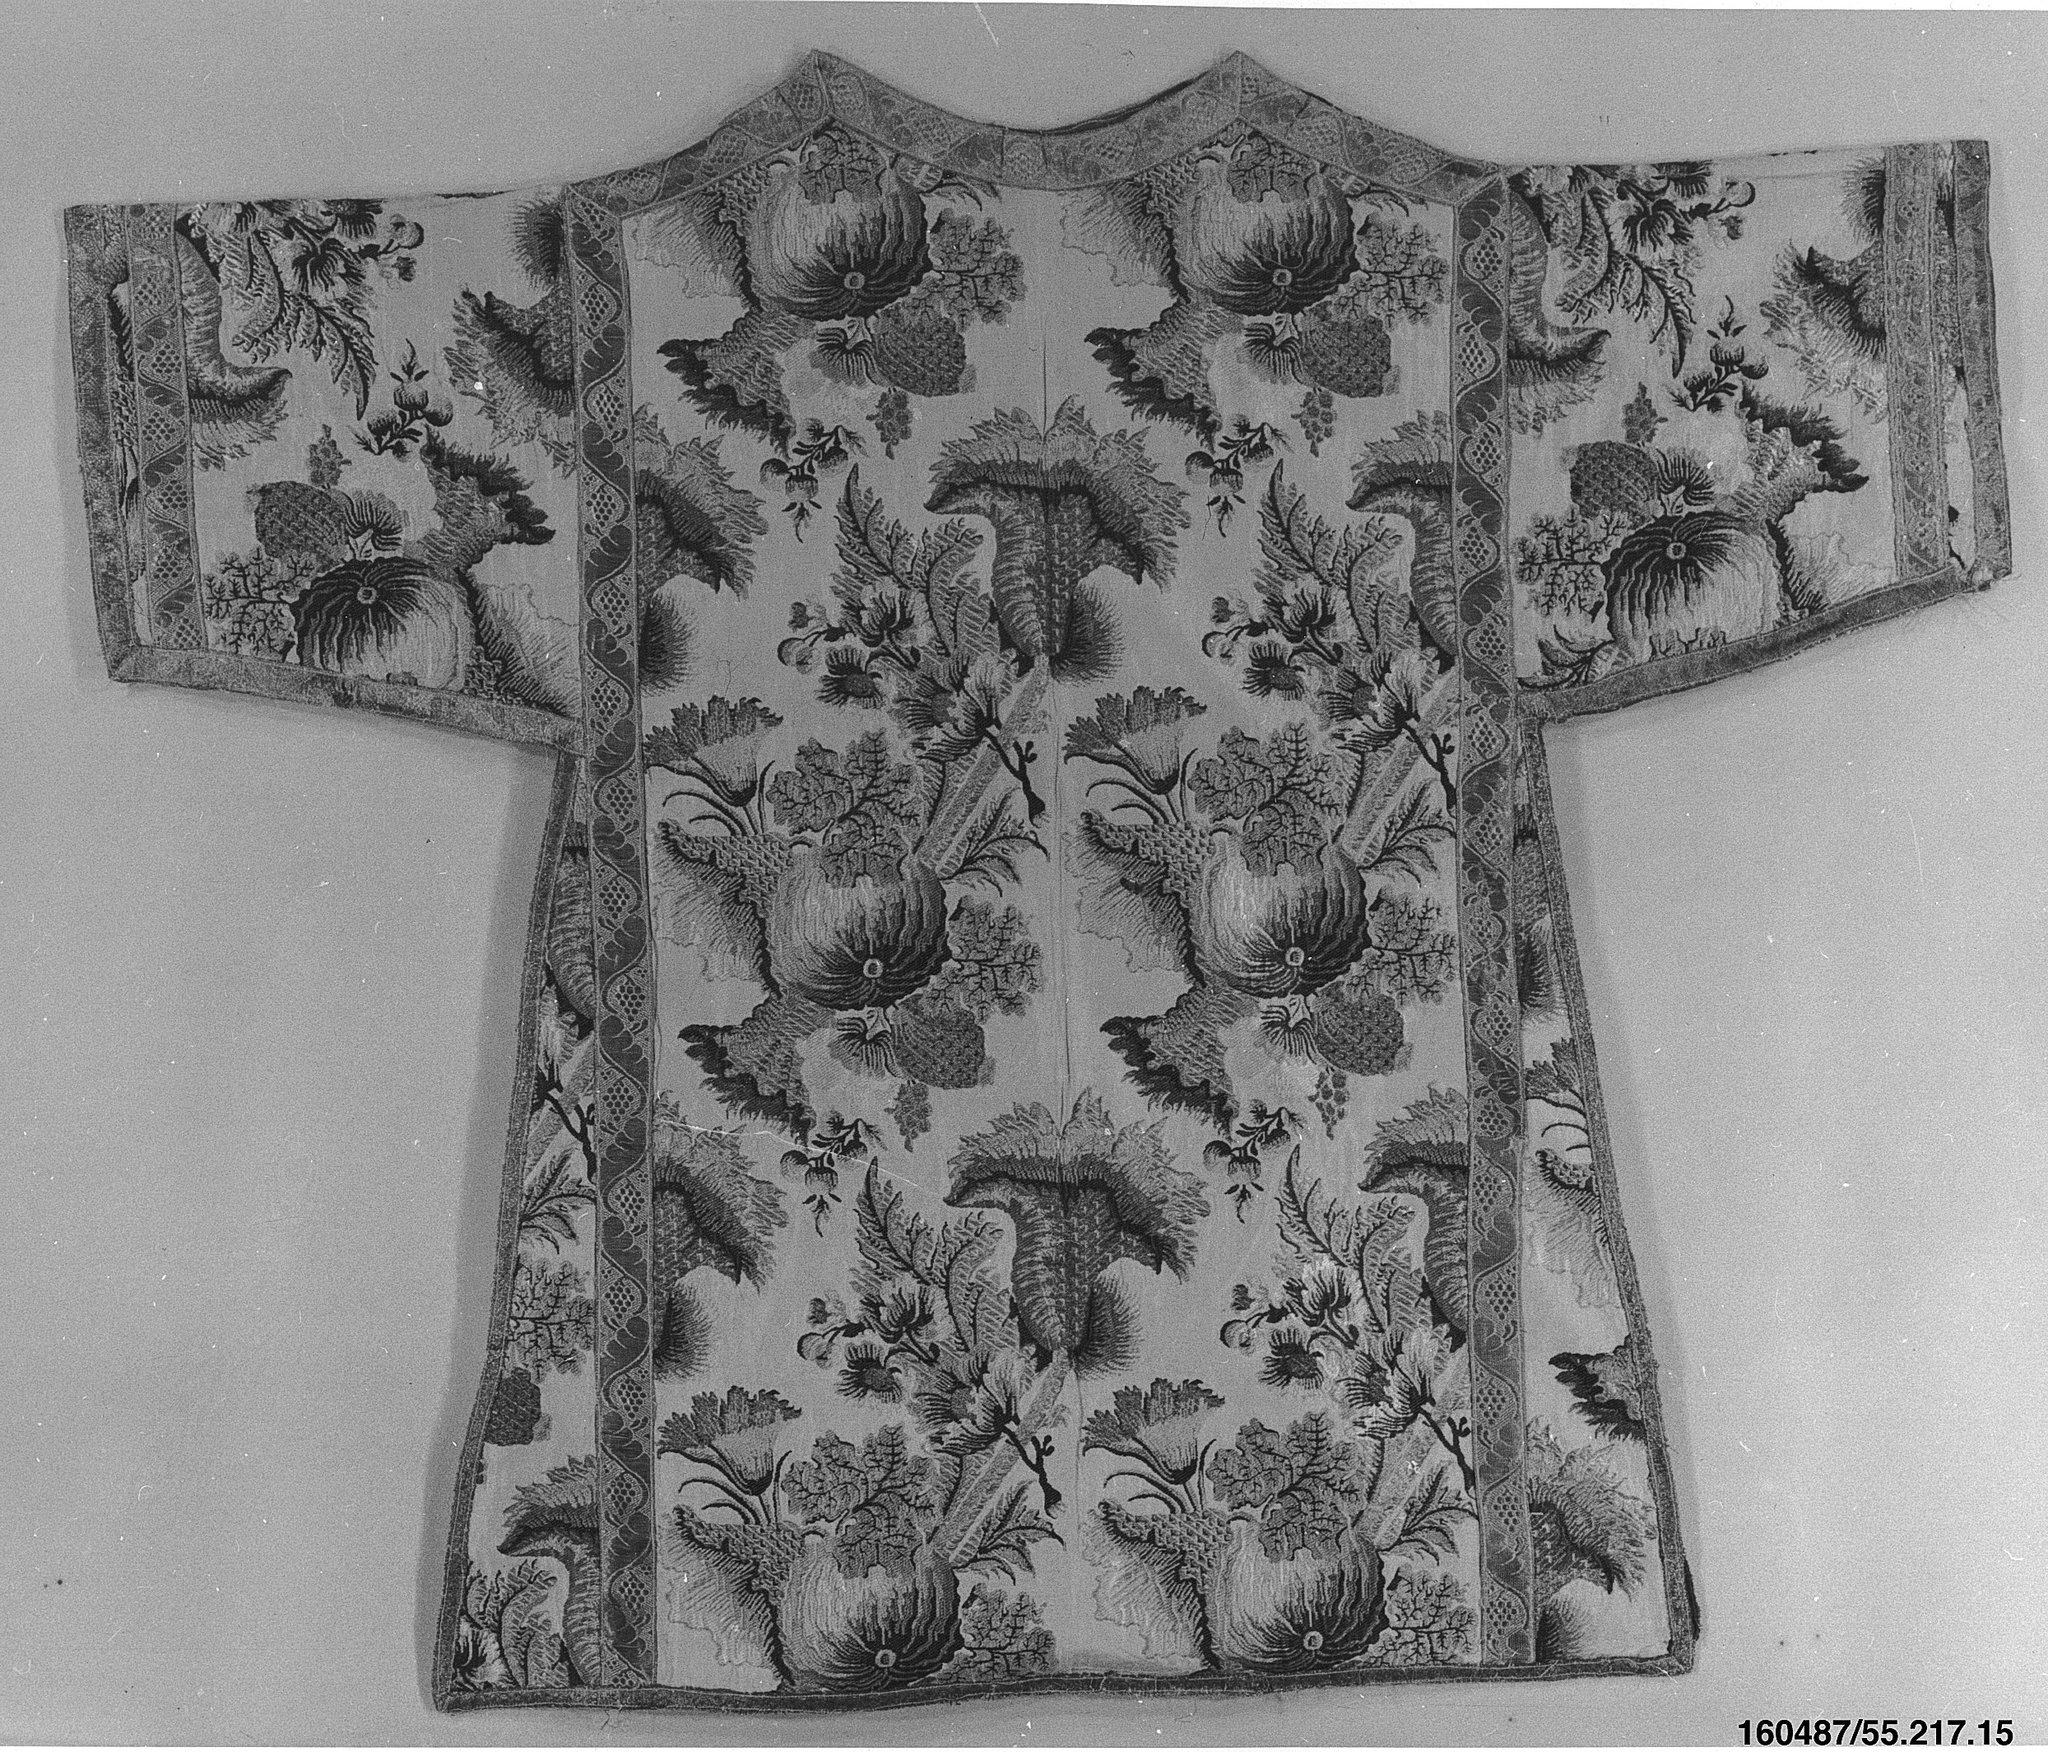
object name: dalmatic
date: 1735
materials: metal thread, silk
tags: flowers